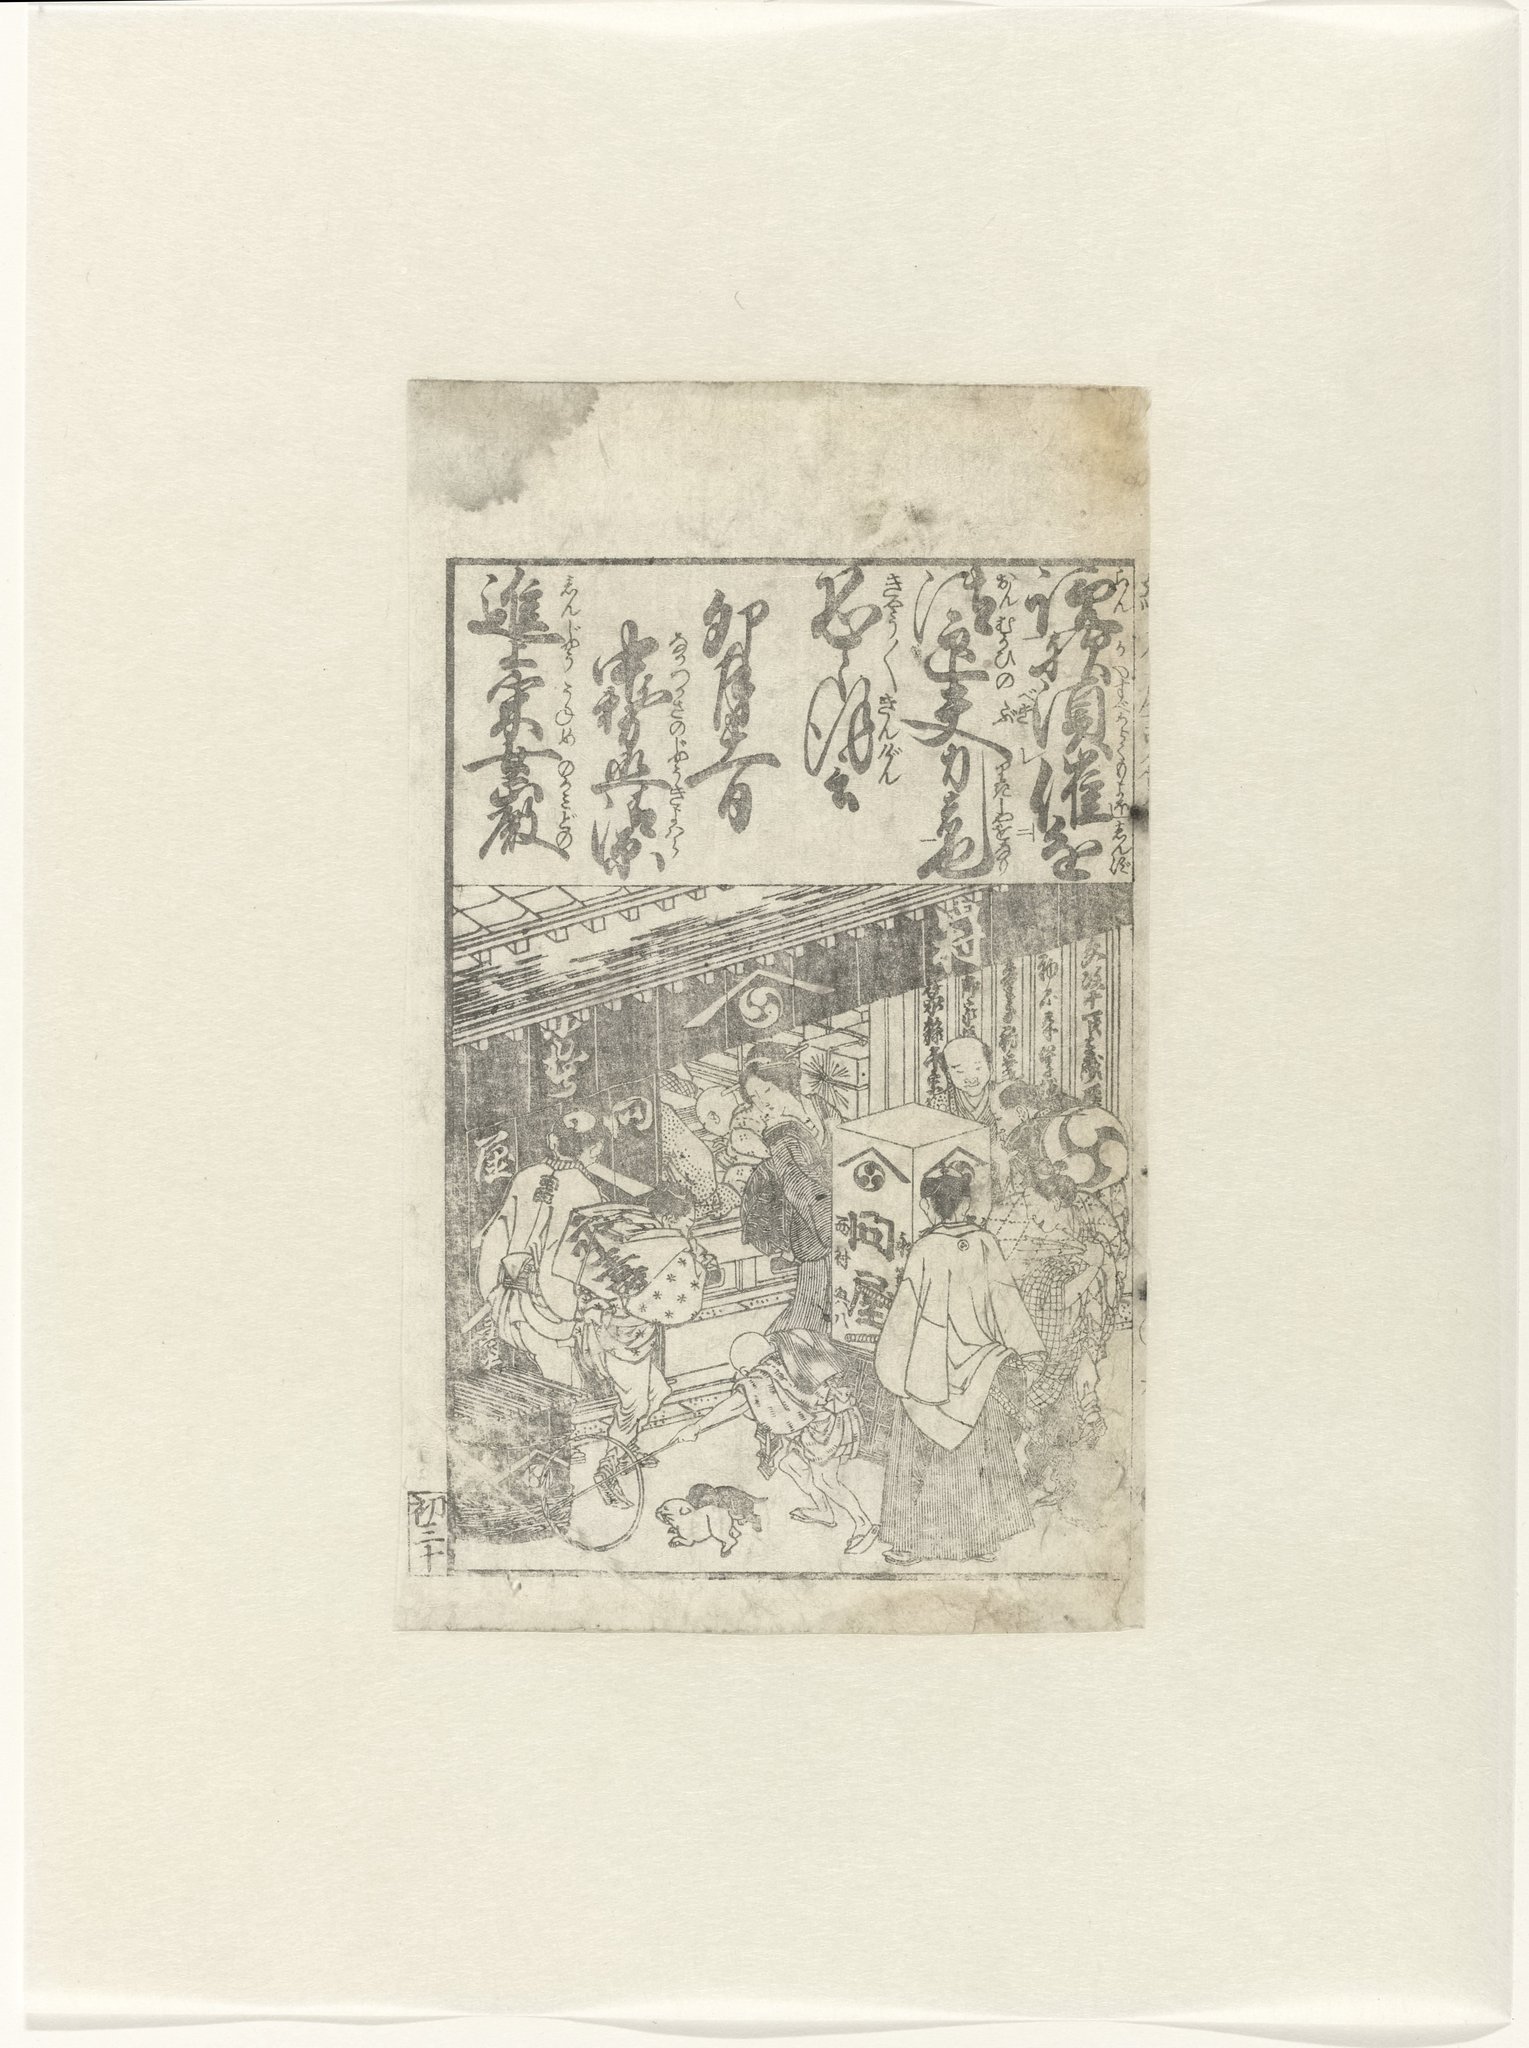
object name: print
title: Boekwinkel in Edo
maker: Anonymous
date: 1750-1800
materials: paper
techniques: woodcut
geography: japan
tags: book-shop, bookseller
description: Gezicht op de gevel van een boekwinkel met voorbijgangers.